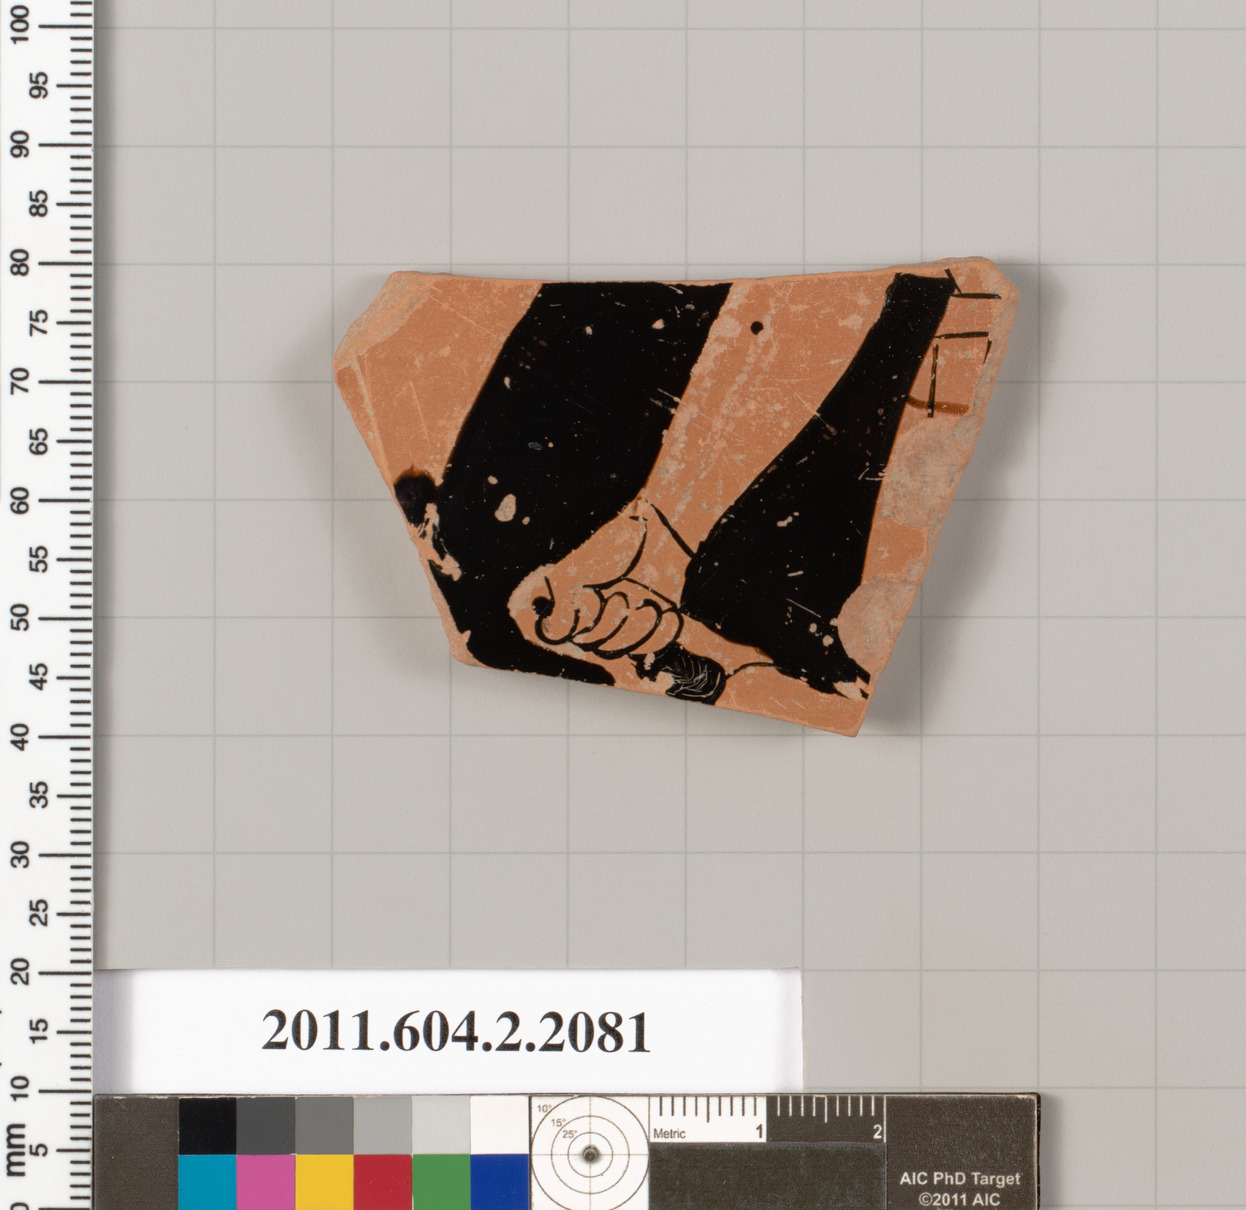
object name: pot fragment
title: Terracotta fragment of a pot; glazed on the inside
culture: greek, attic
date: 450-426 BCE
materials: terracotta